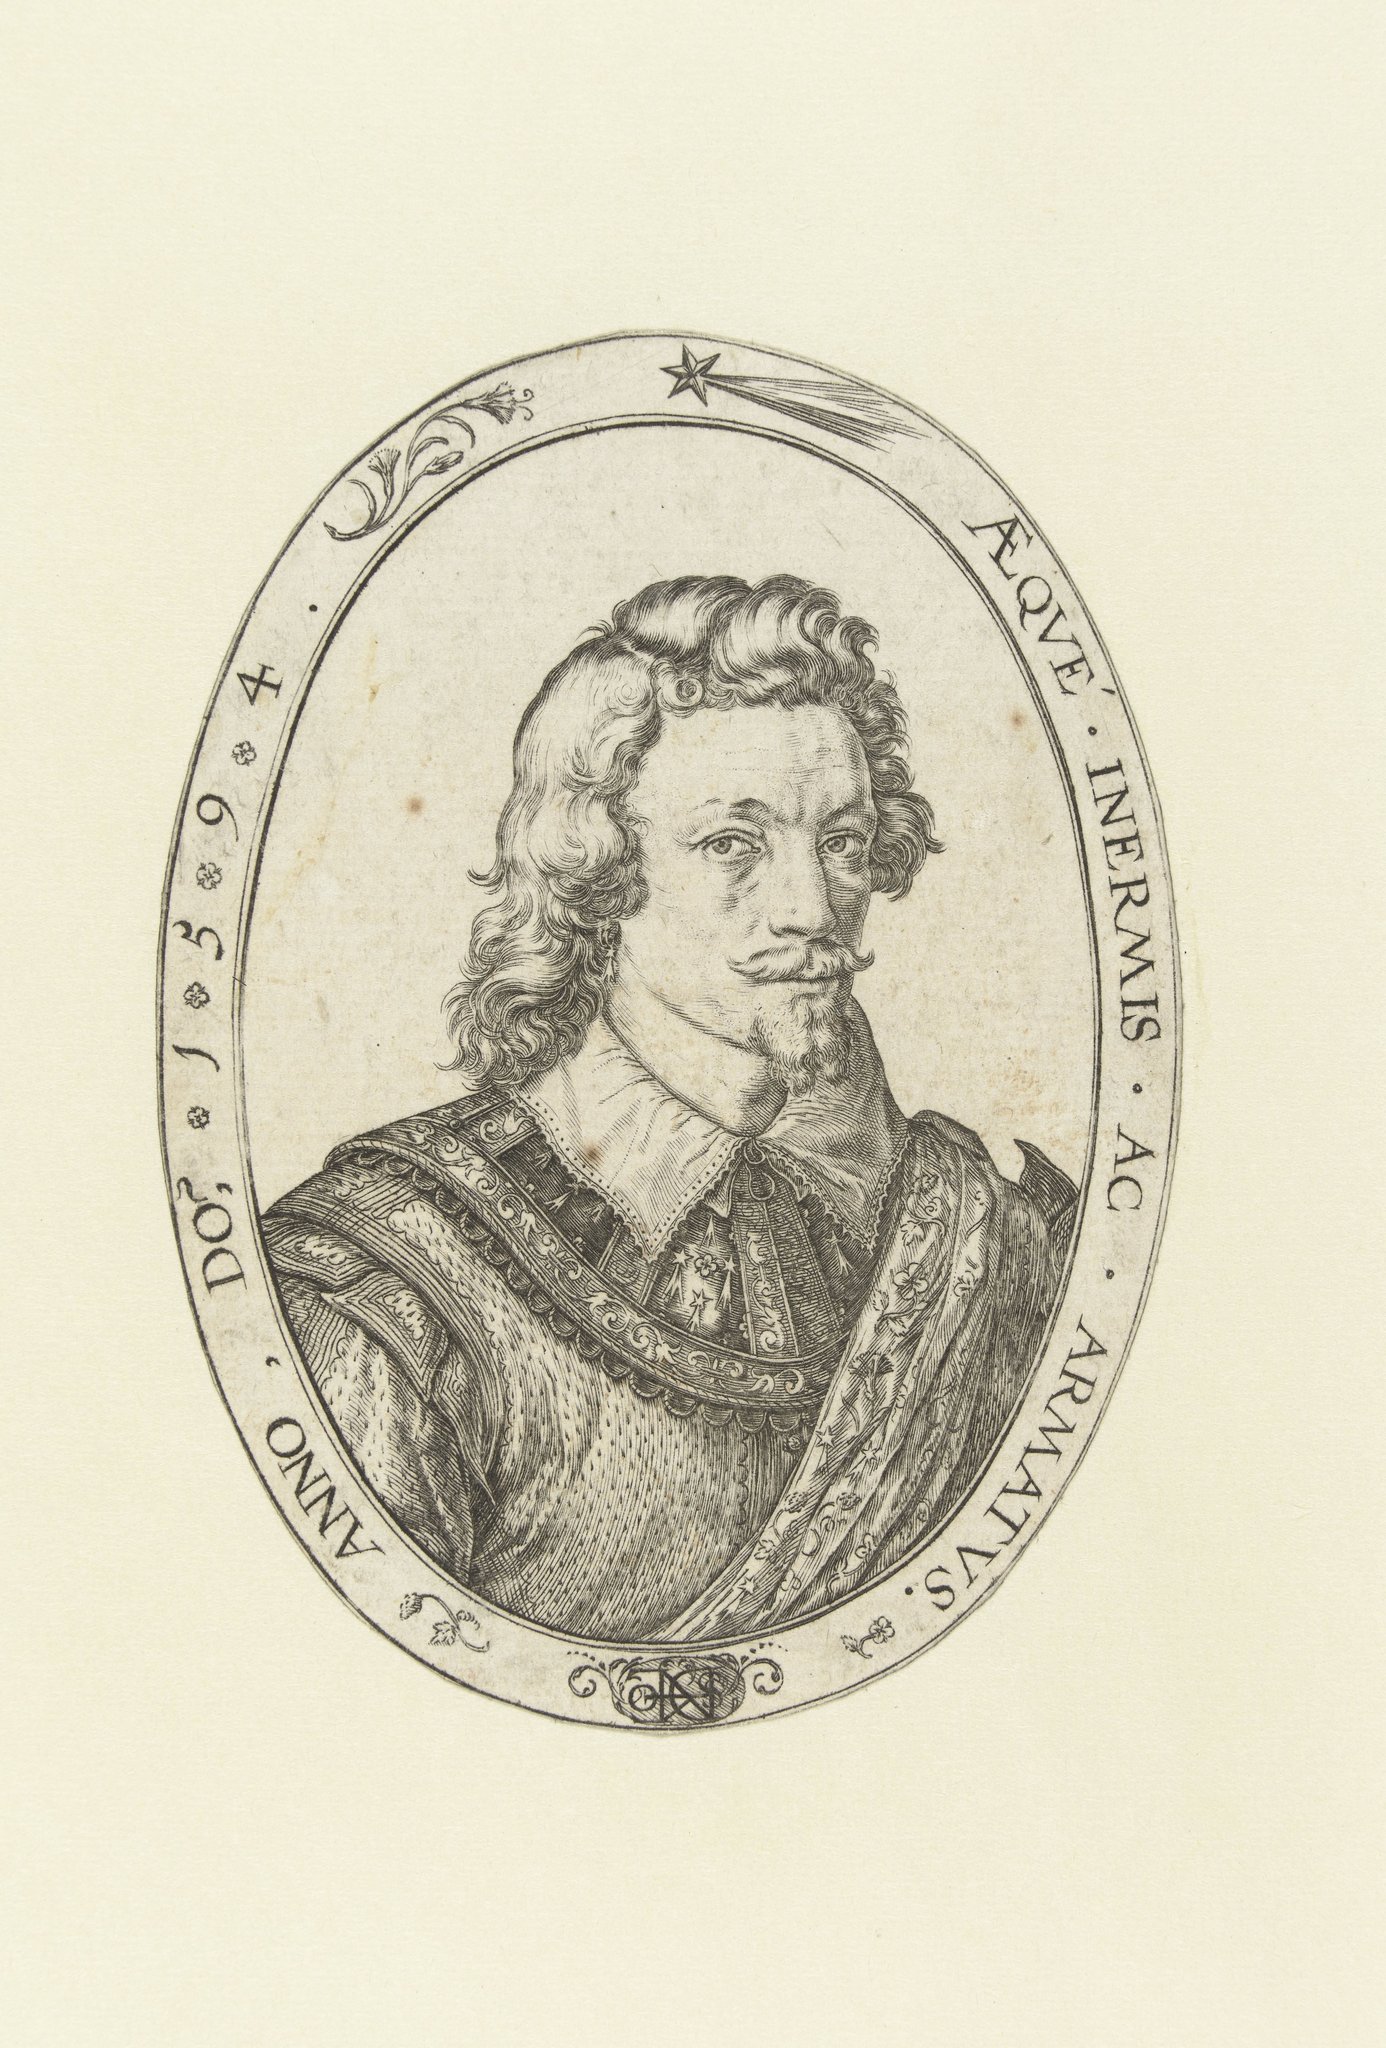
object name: print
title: Portret van een man met een sjerp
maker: jacques de gheyn (ii)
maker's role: painter, print maker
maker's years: 1565-1629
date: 1594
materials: paper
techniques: engraving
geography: netherlands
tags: anonymous historical person portrayed alone (+ (full) bust portrait)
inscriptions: collector's mark: Lugt 2228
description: Portret van een onbekende man met halflang haar, snor en sikje, hooggesloten kraag en sjerp om de linkerschouder, in ovaal met Latijns randschrift.